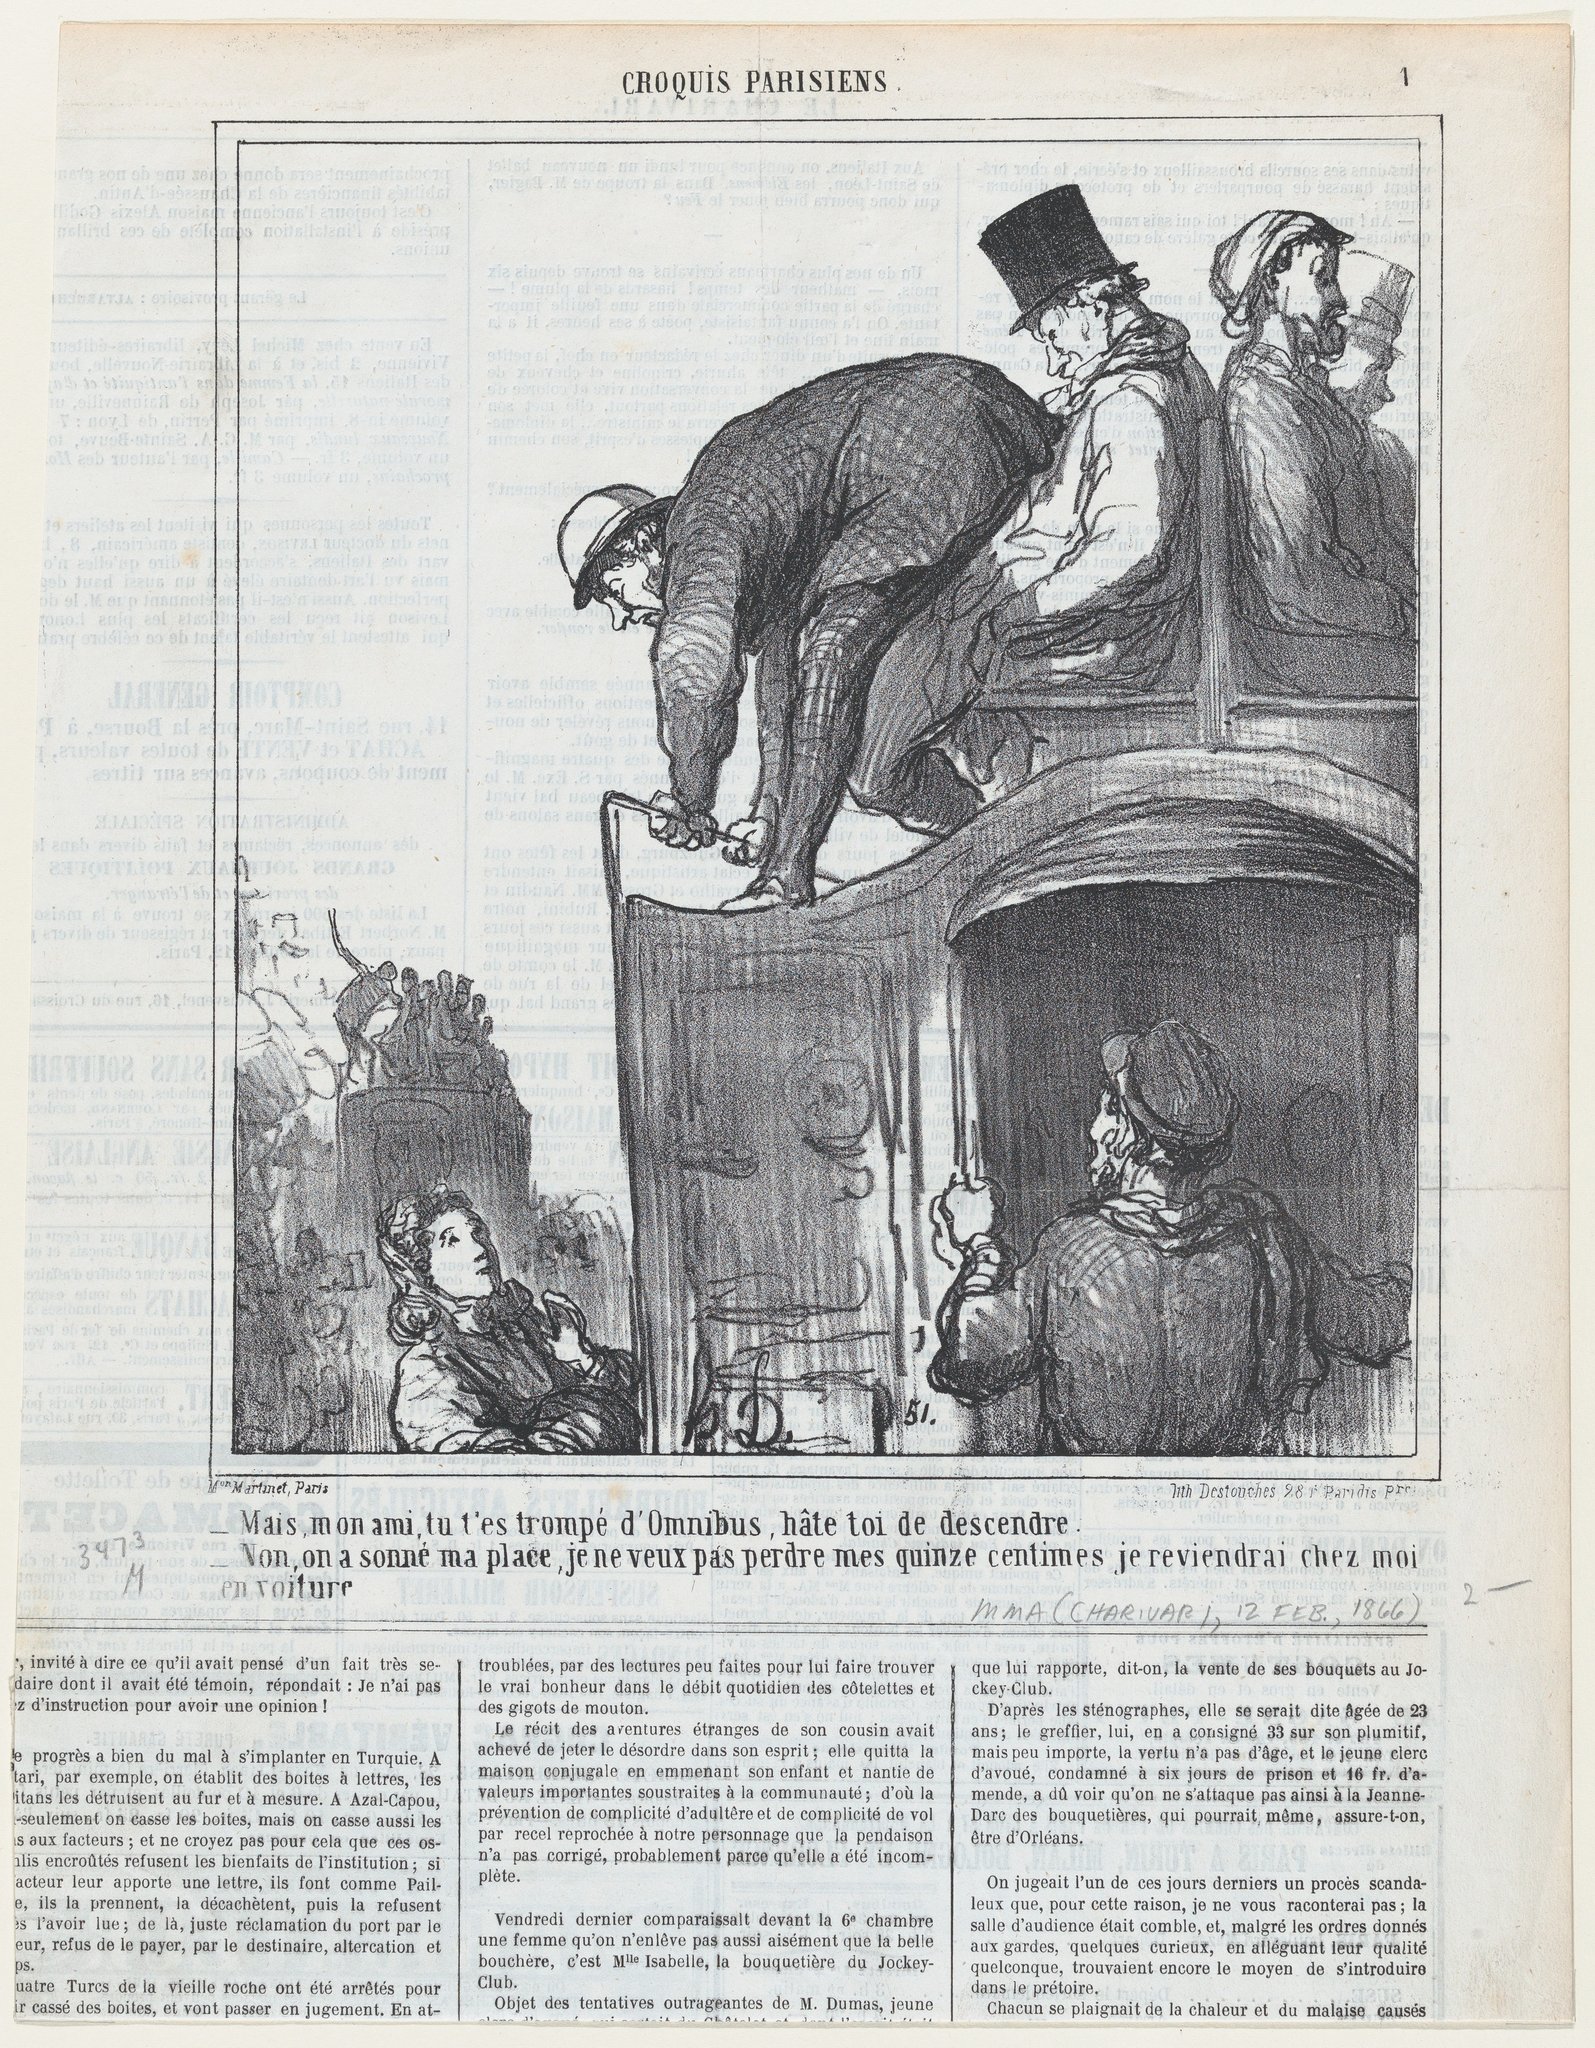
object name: print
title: My friend, you have taken the wrong bus, get out quickly!, from 'Parisian sketches,' published in Le Charivari, January 31, 1866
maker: honoré daumier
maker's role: artist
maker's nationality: french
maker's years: 1808-1879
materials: paper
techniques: lithograph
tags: men,women,buses